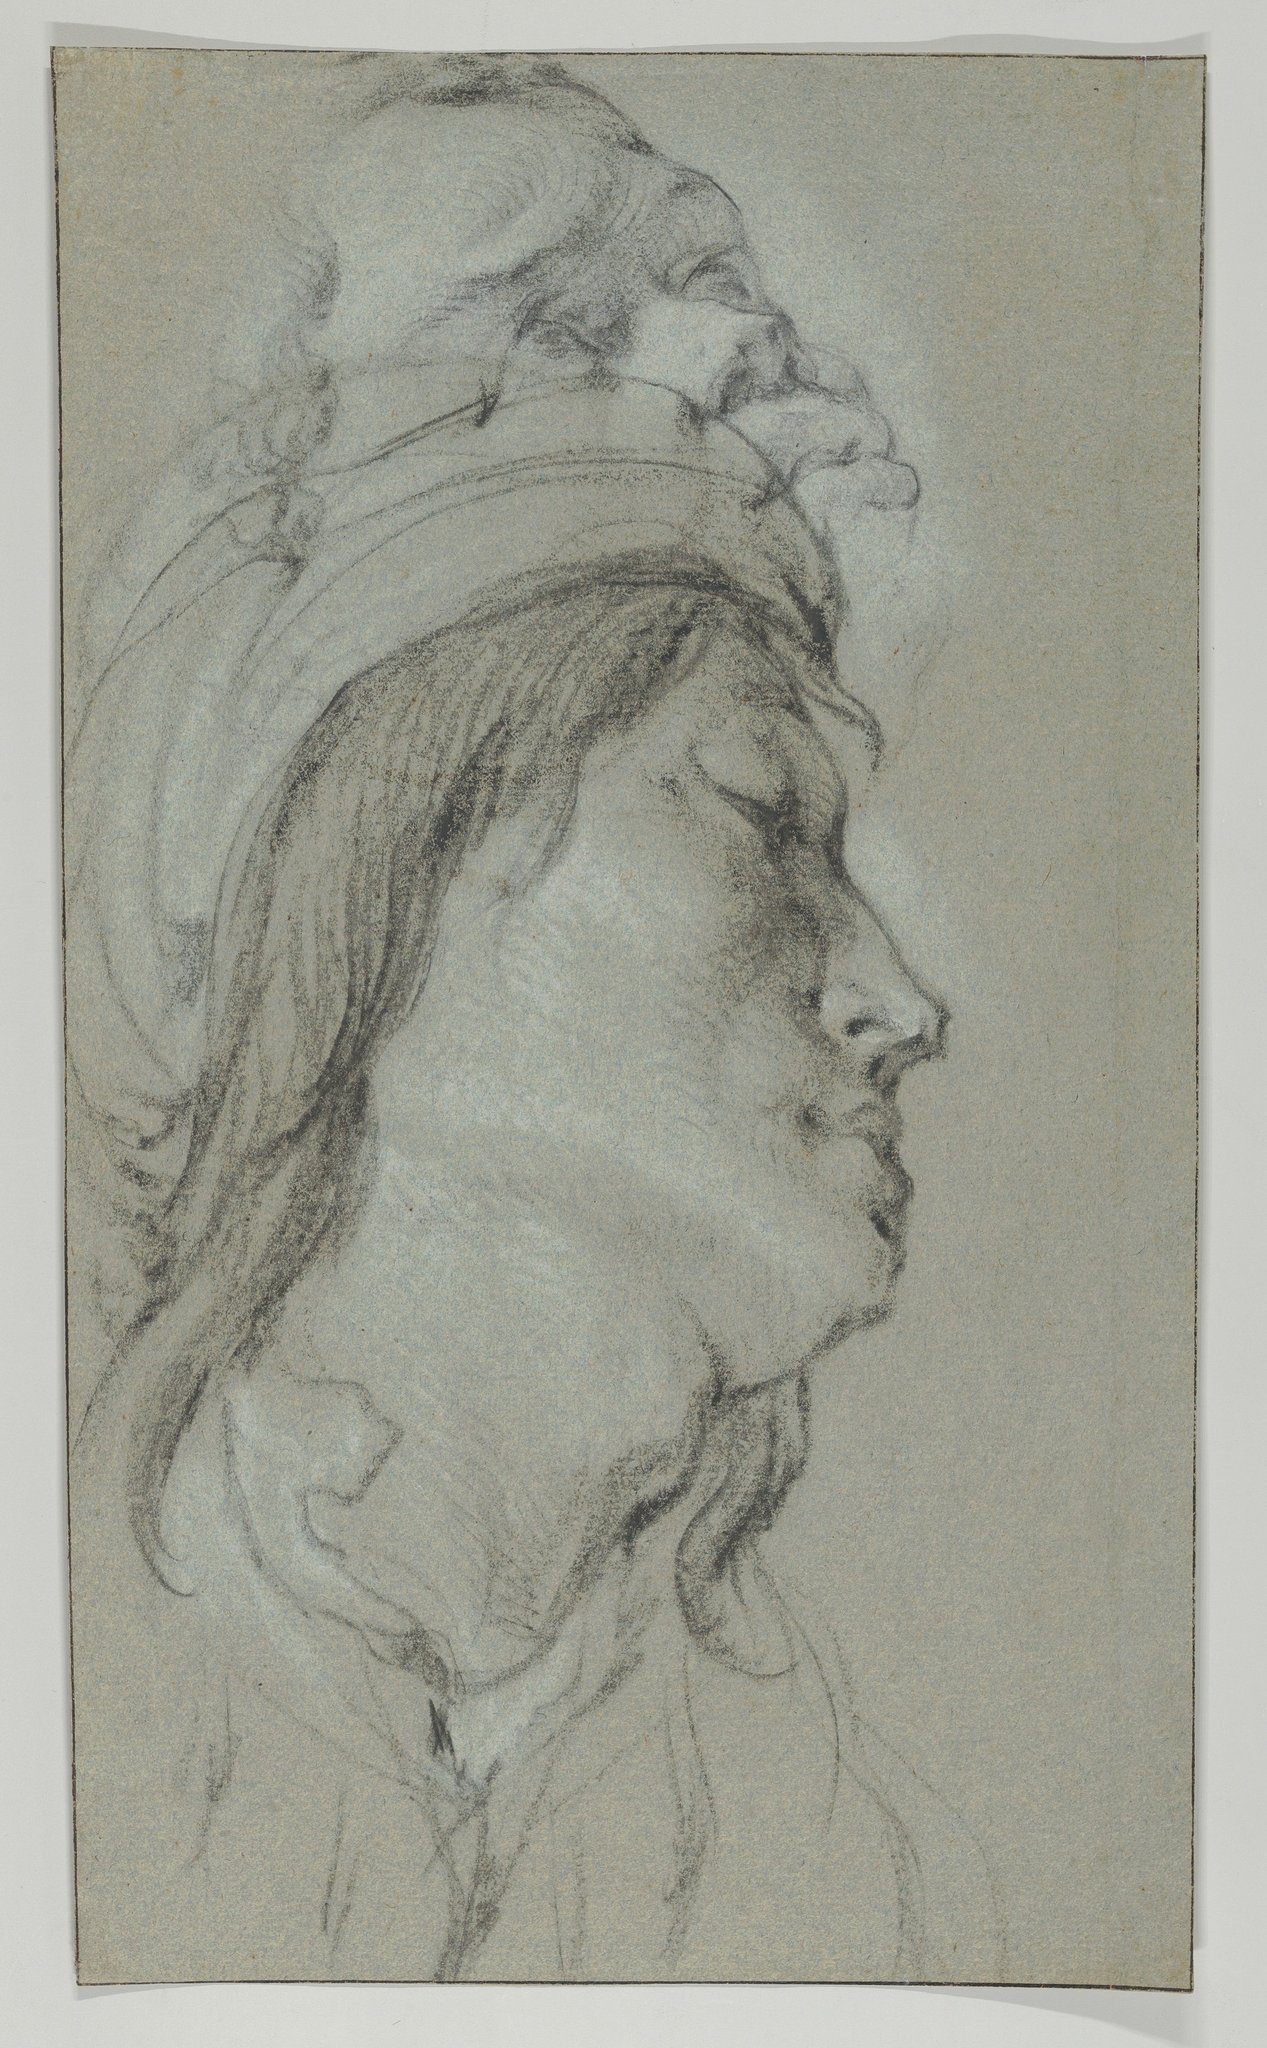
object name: drawing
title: Head Studies of A Young Man Wearing a Hat and of a Black Man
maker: lucas franchoys the younger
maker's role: artist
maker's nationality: flemish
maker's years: 1616-1681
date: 1634-1666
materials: chalk, ink, paper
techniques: pen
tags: heads,men